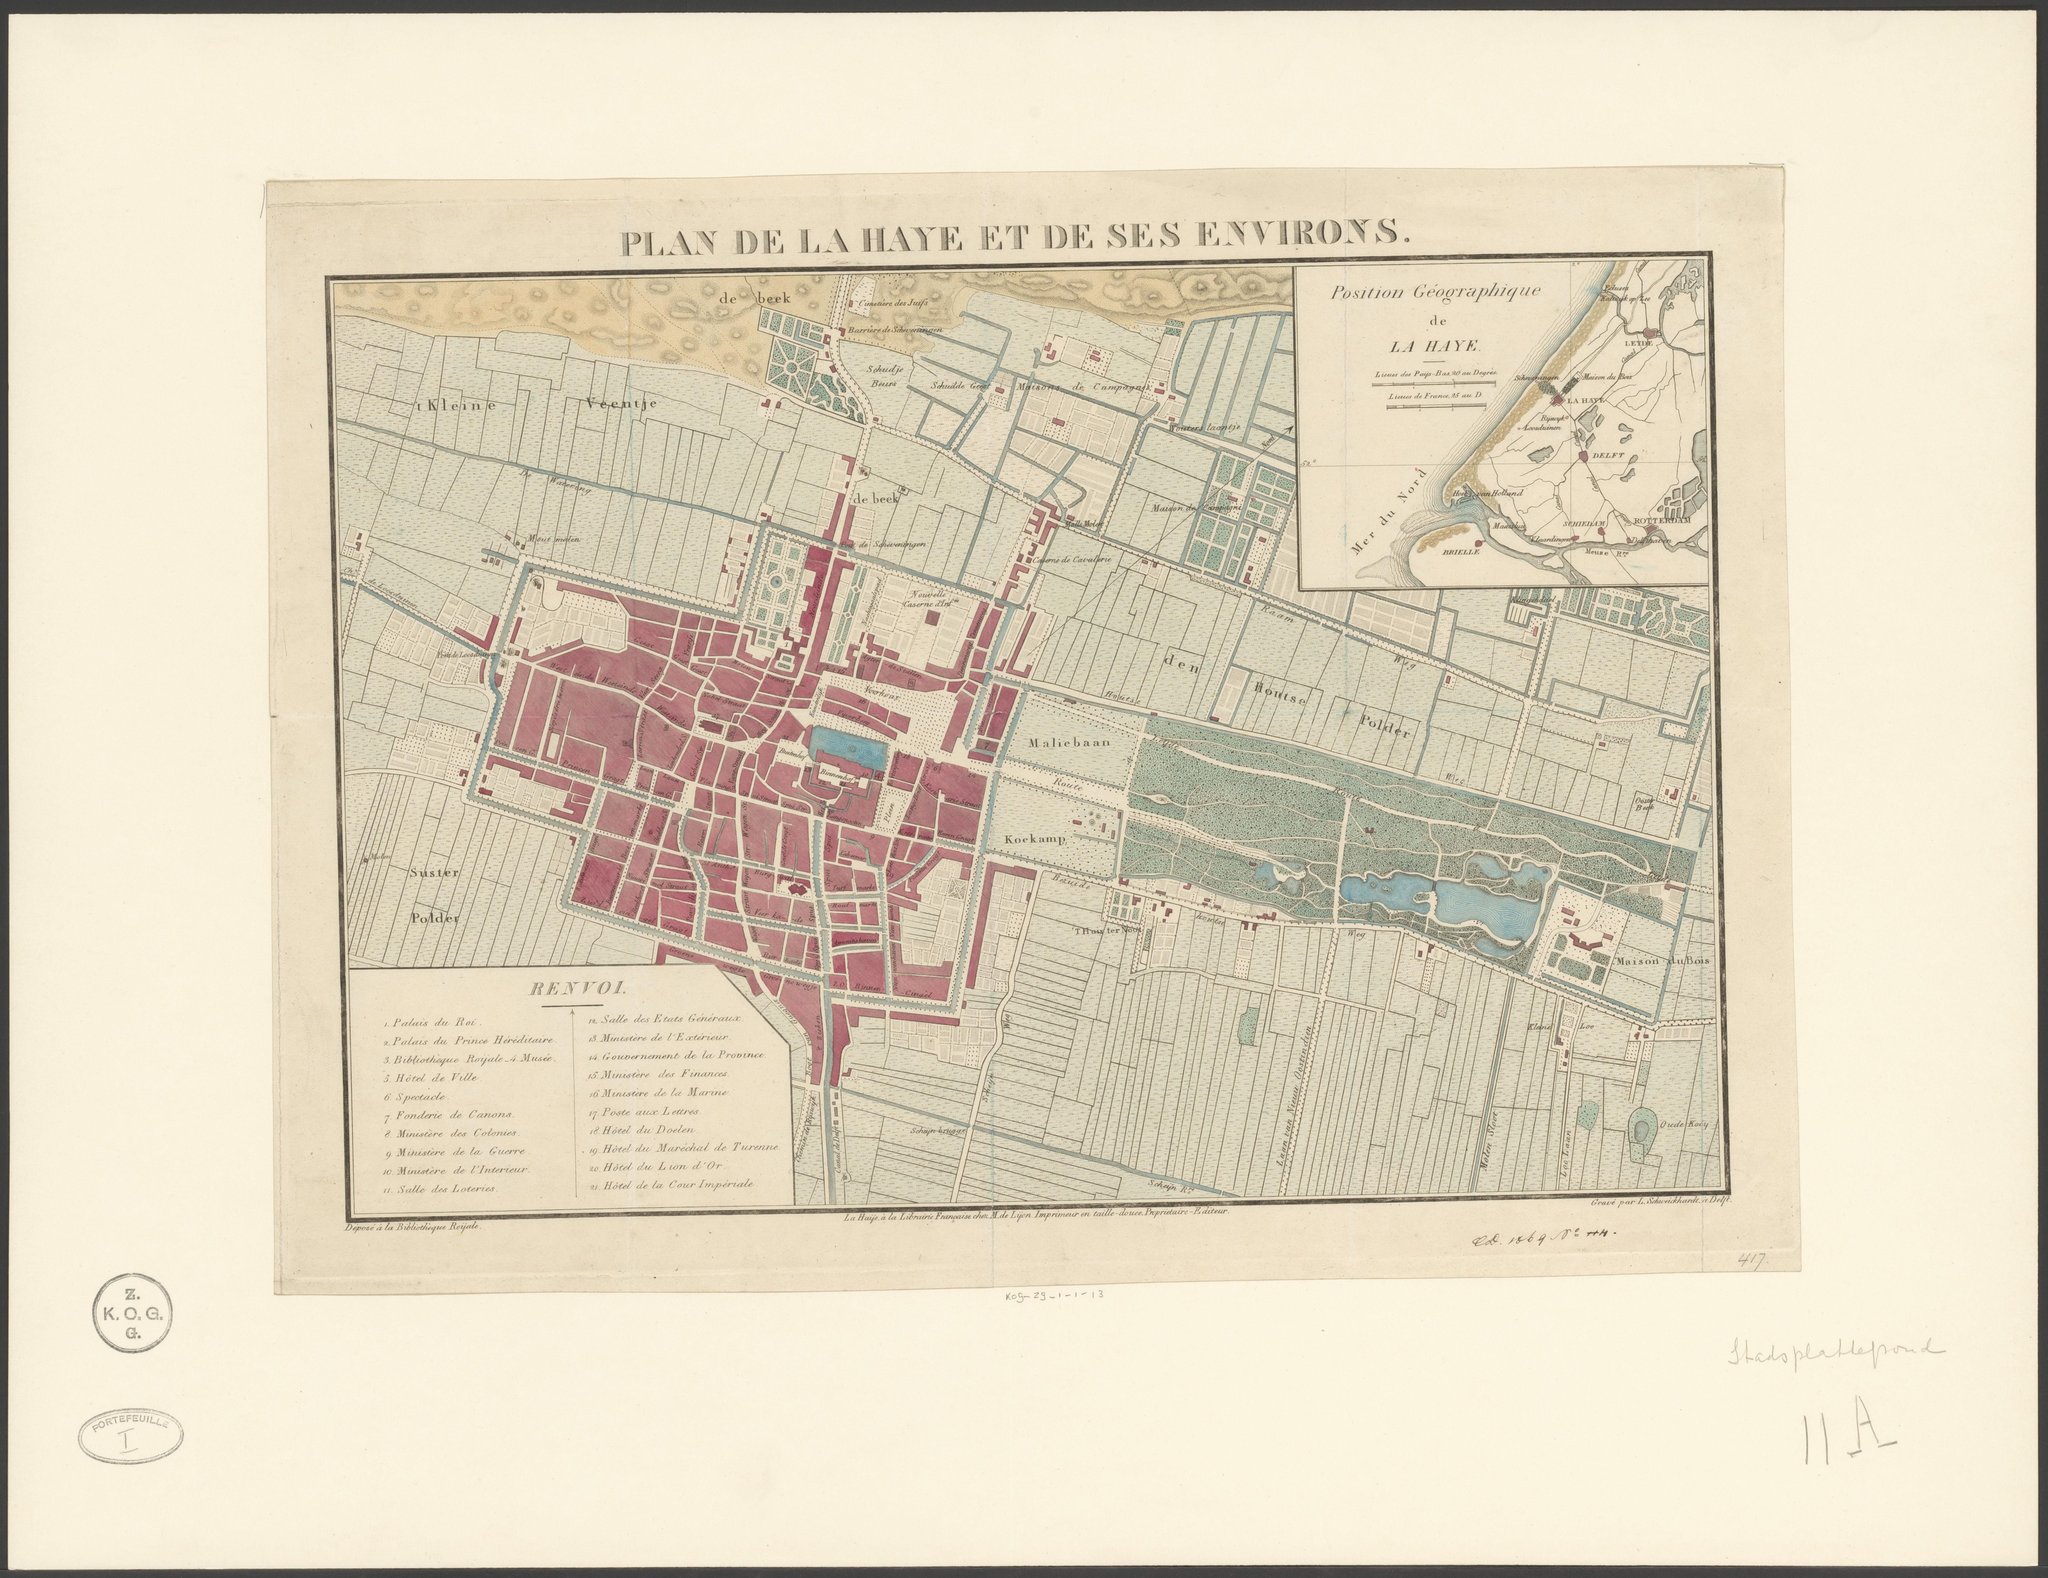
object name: area plan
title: Plan de la Haye et de ses environs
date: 1820-1843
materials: paper, watercolor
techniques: etching, hand coloring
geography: delft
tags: maps of cities, the hague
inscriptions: copyright notice: ‘Déposé à la Bibliothèque Royale’, collector's mark, collector's mark: Lugt 1641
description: Plattegrond van de stad Den Haag en omstreken. Rechtsboven een inzet met een kaartje met de geografische ligging van Den Haag in het wijder gebied. Linksonder de legenda 1-21. Onderwerpsrubrieken binnen de Atlas Zeden en Gewoonten: topografie; plattegronden.